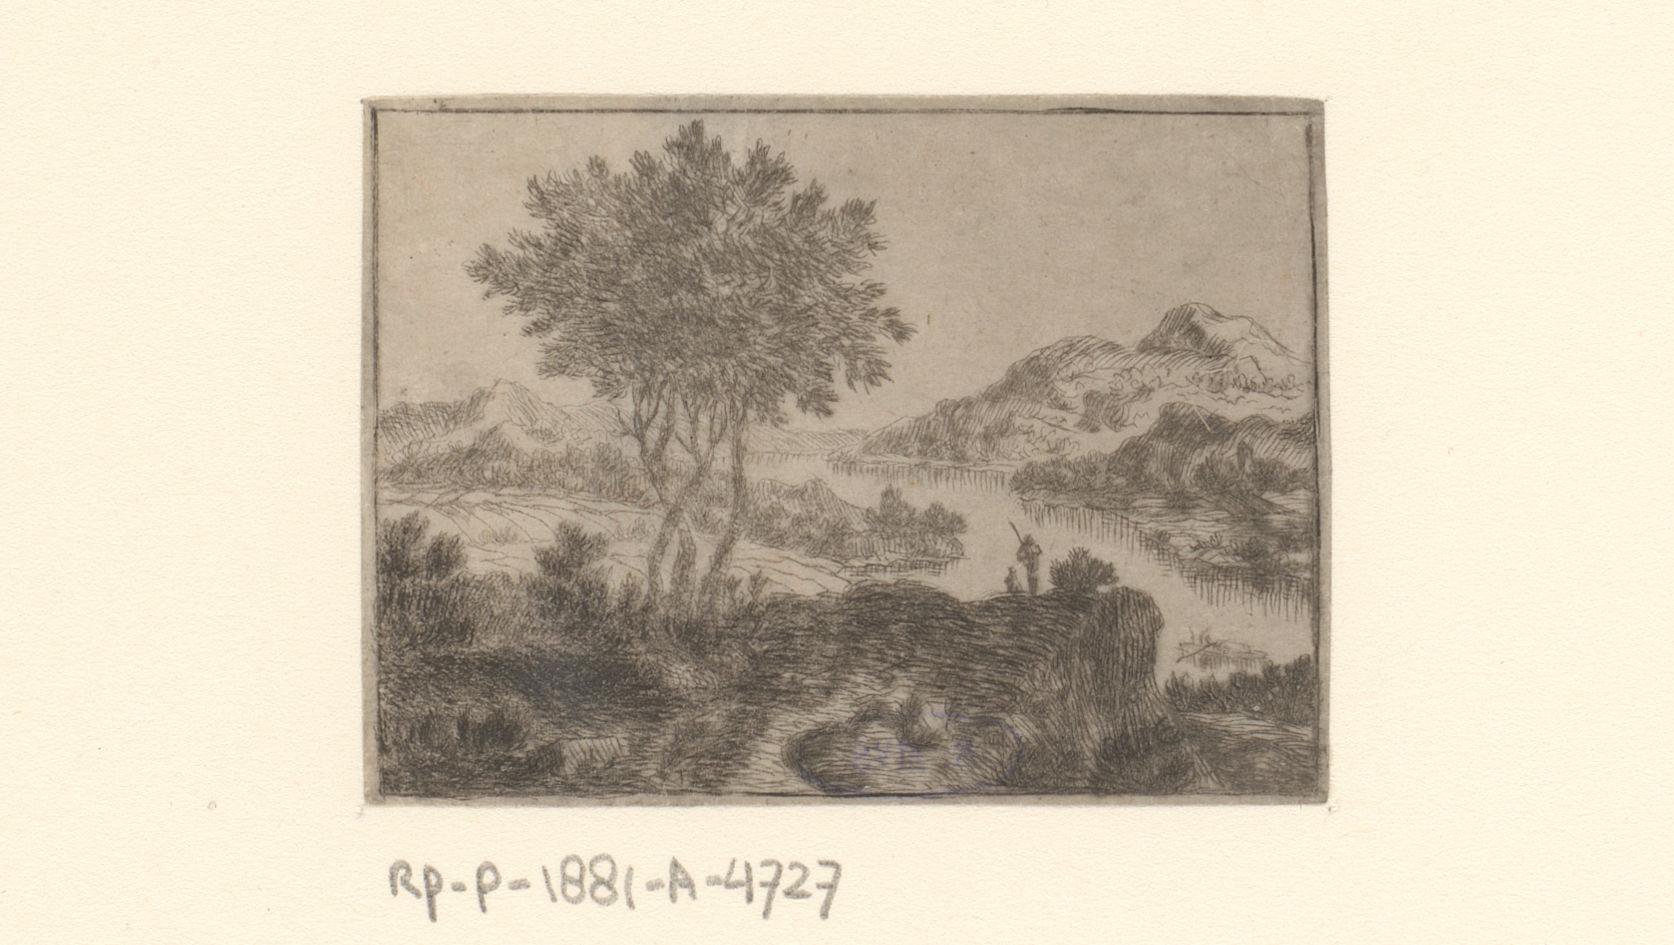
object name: print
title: Heuvelachtig landschap met rivier en hengelaar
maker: herman saftleven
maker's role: draughtsman, painter, print maker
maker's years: 1609-1685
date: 1619-1685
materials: paper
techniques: etching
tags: river, (high) hill, angling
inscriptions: collector's mark: Lugt 2228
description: Anonieme prent, van dezelfde hand als RP-P-1880-A-4452.